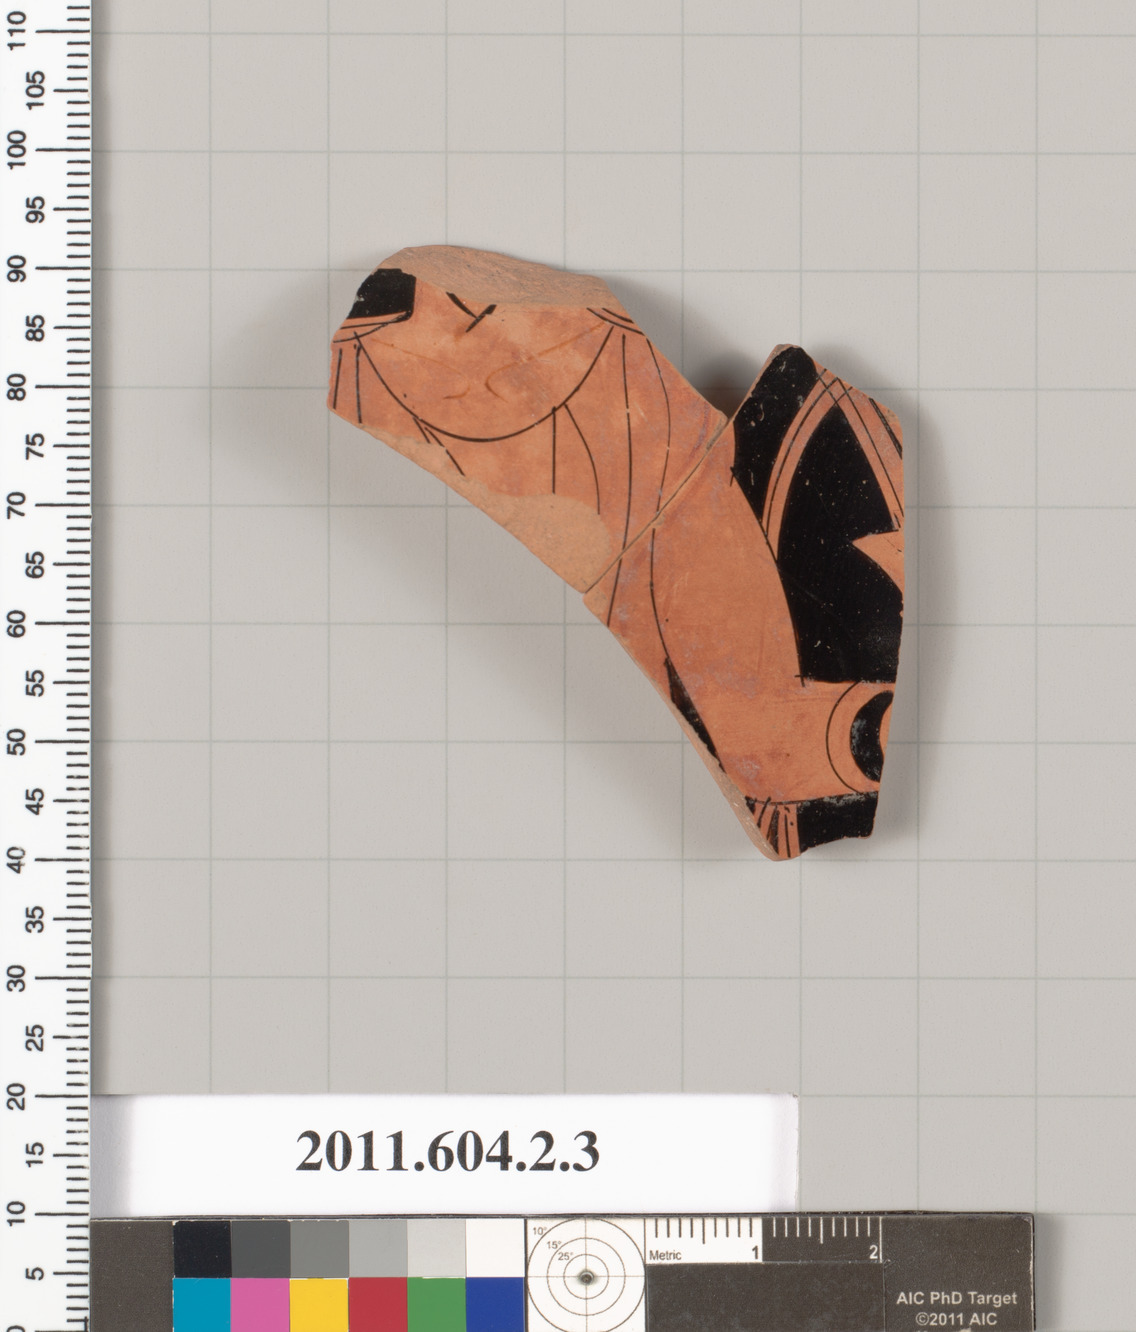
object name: neck amphora fragment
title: Terracotta fragment of a neck-amphora (jar)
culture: greek, attic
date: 460-450 BCE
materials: terracotta